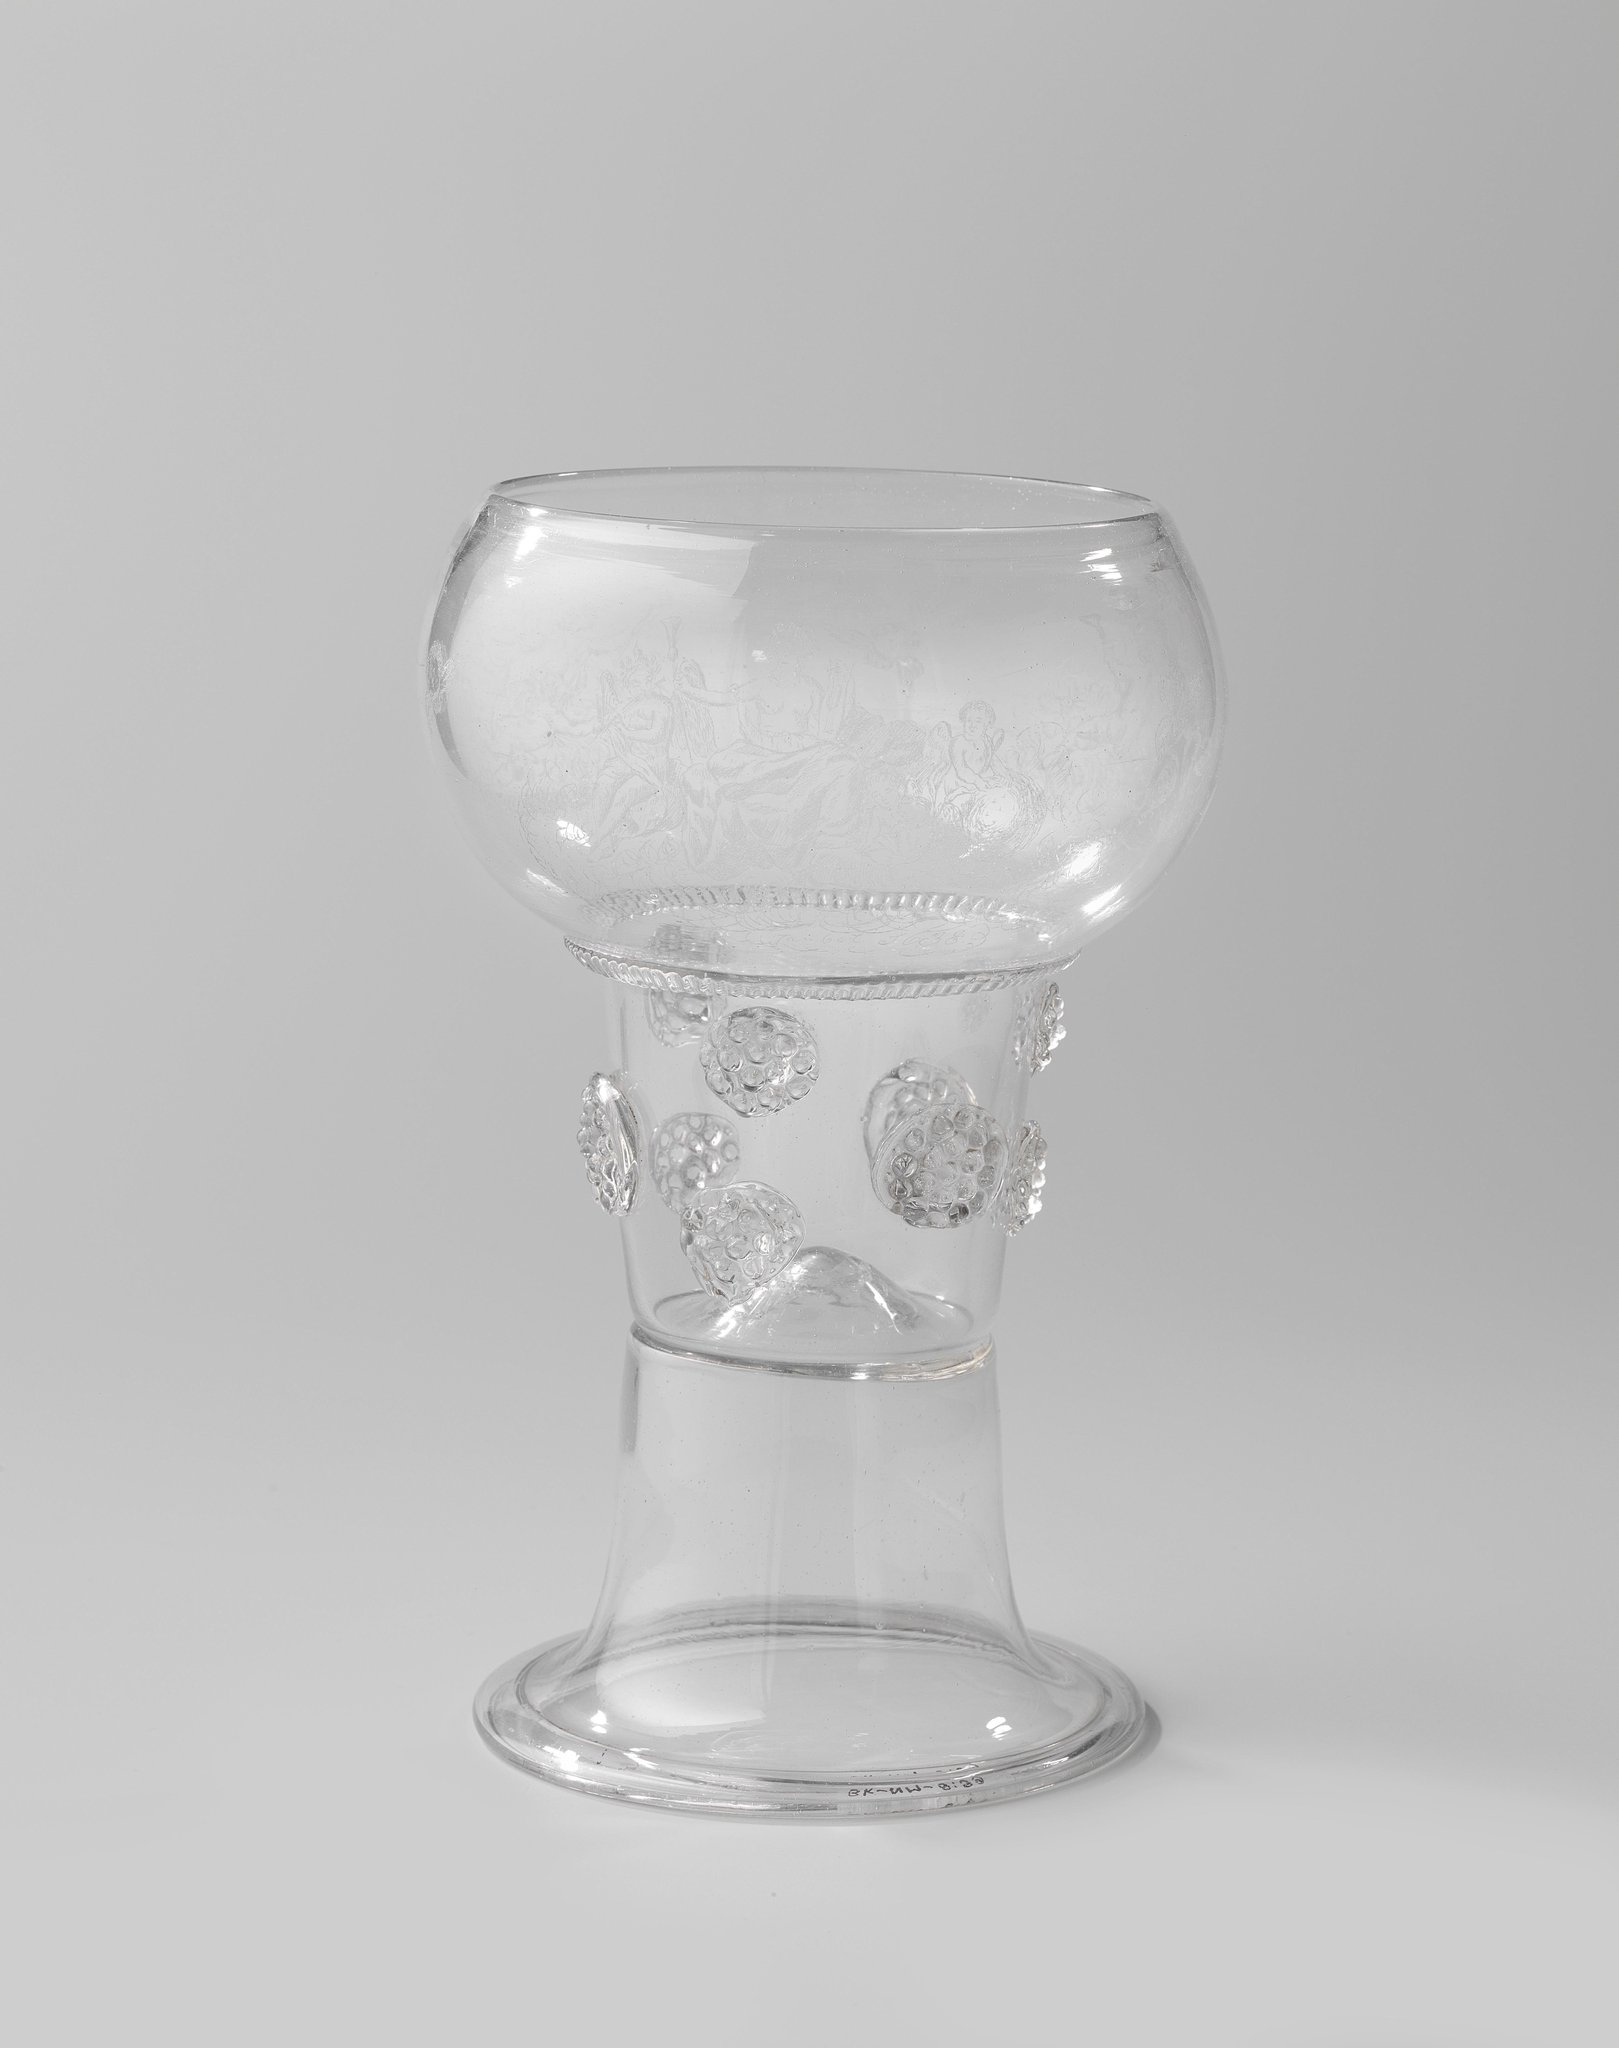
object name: roemer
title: Roemer met onder andere Orpheus met lier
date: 1700-1750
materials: glass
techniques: diamond point engraving, glassblowing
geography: germany